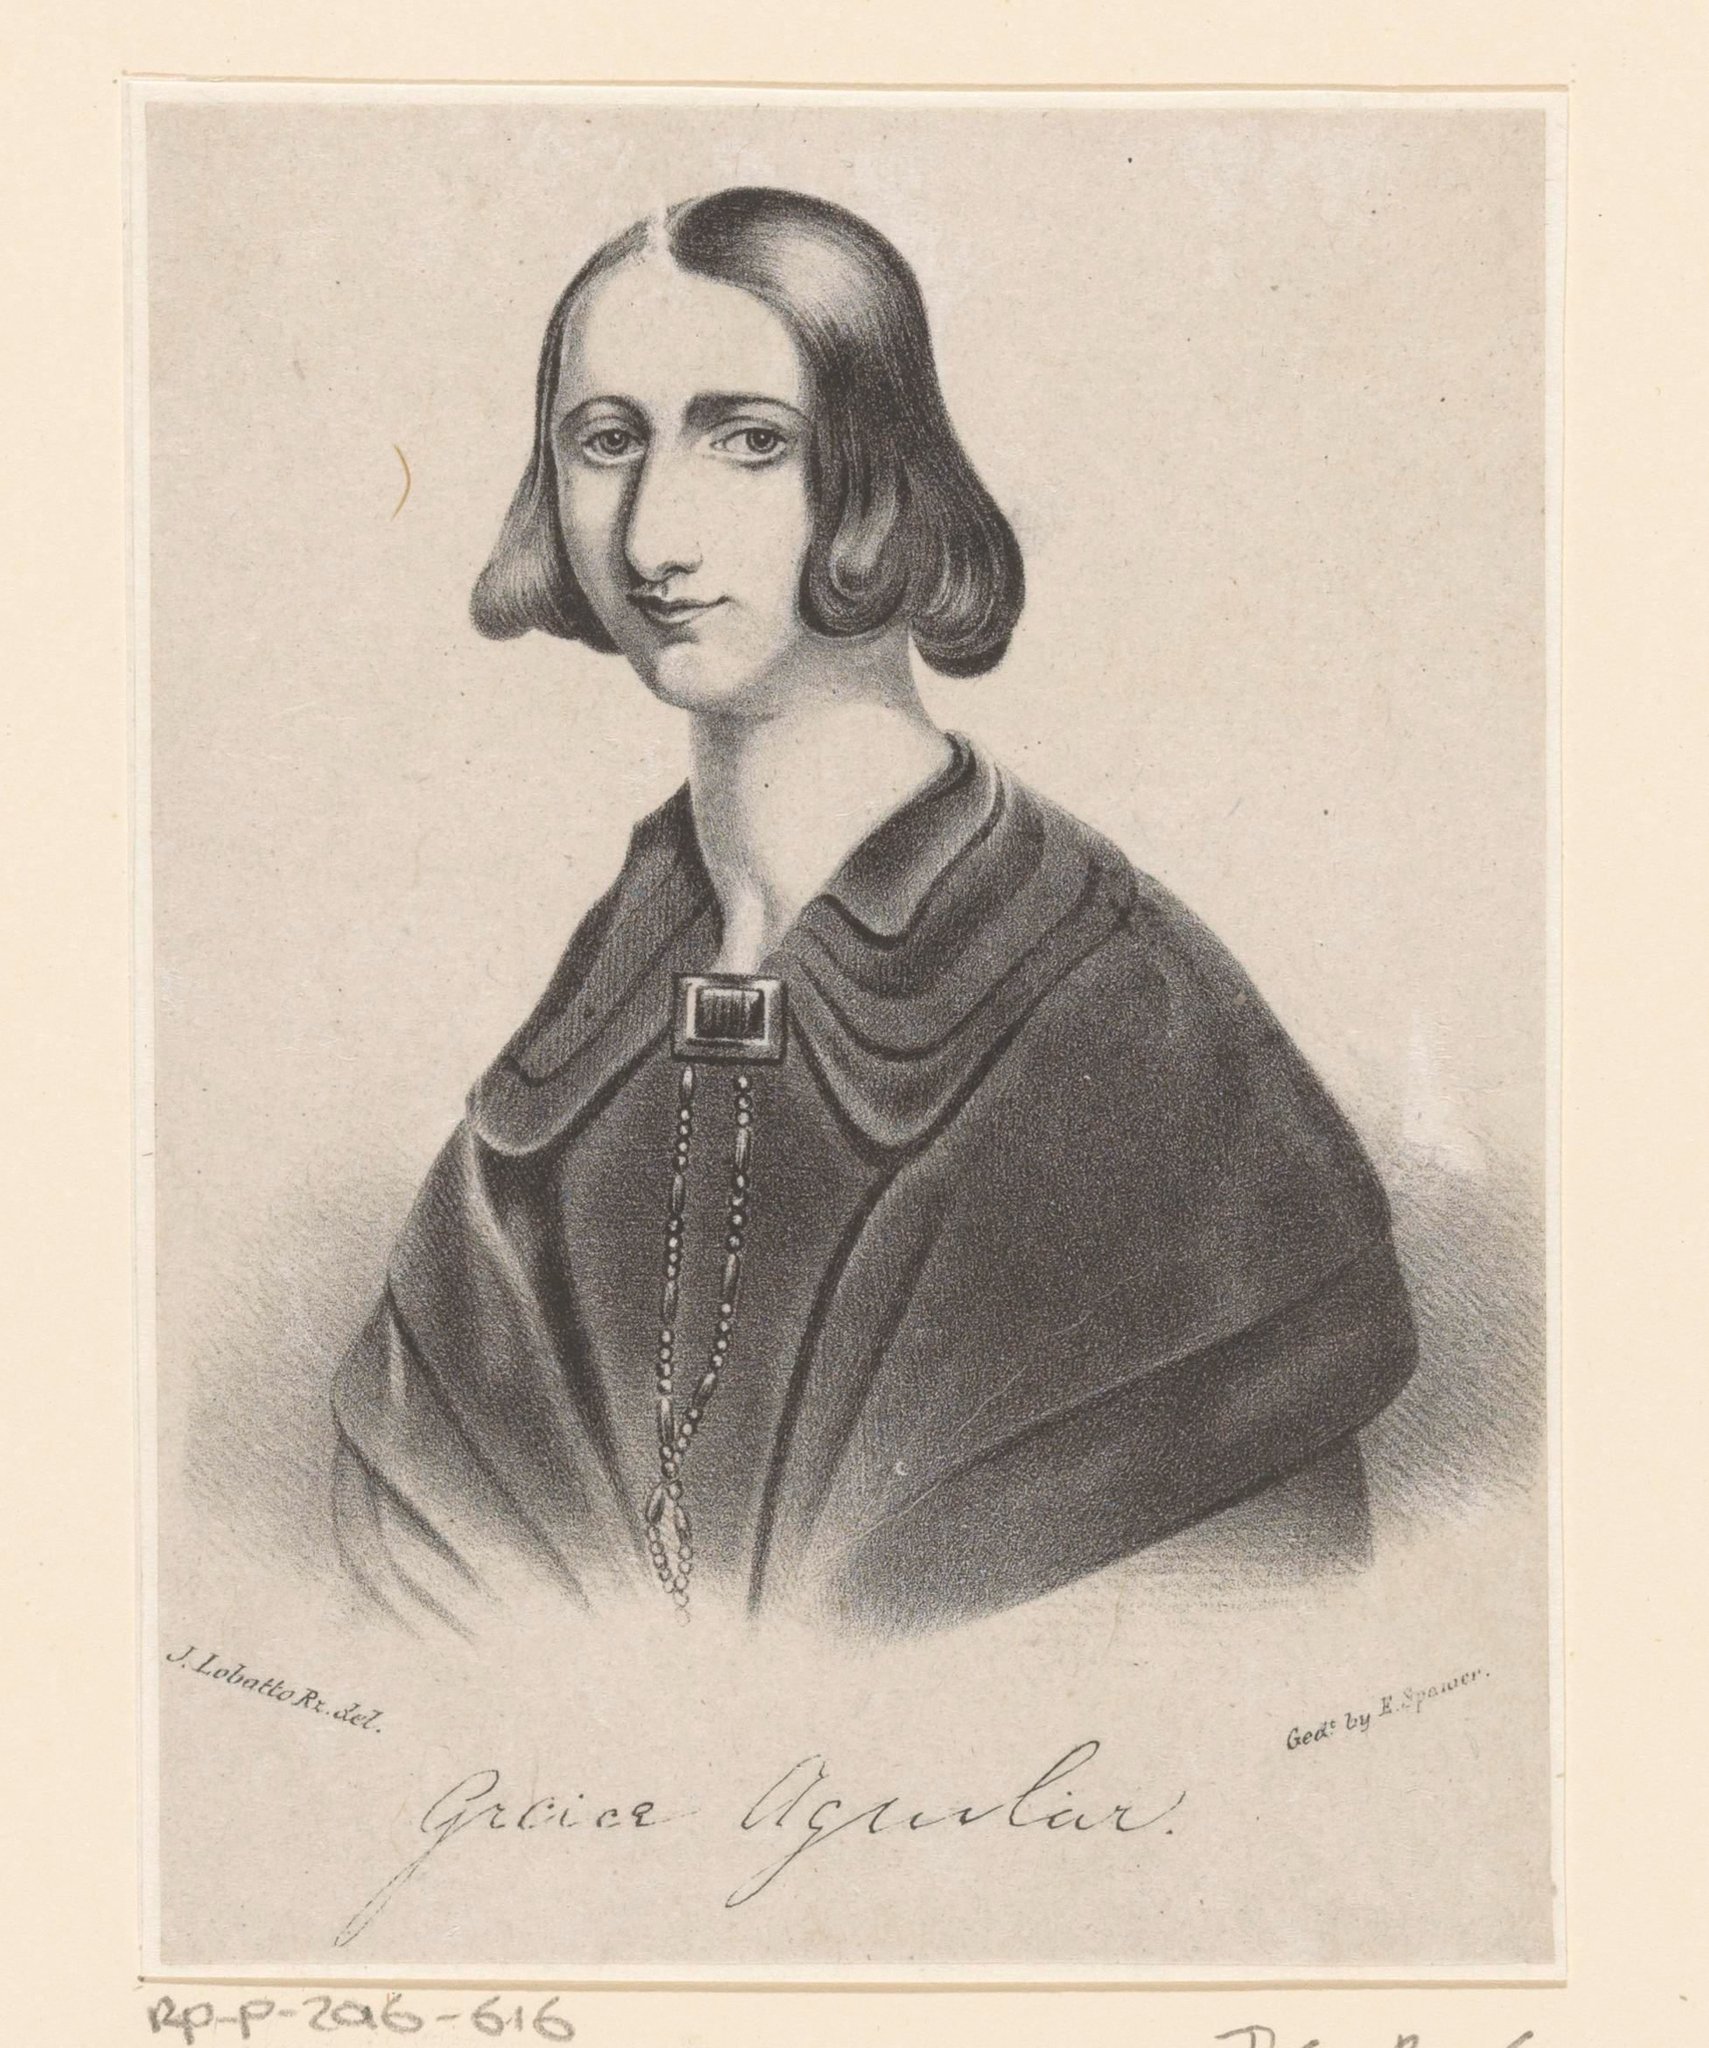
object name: print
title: Portret van Grace Aguilar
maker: elias spanier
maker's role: print maker, printer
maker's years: 1821-1863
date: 1831-1863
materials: paper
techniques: lithograph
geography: the hague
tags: portrait of a writer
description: Portret van Grace Aguilar. In de ondermarge haar naam.